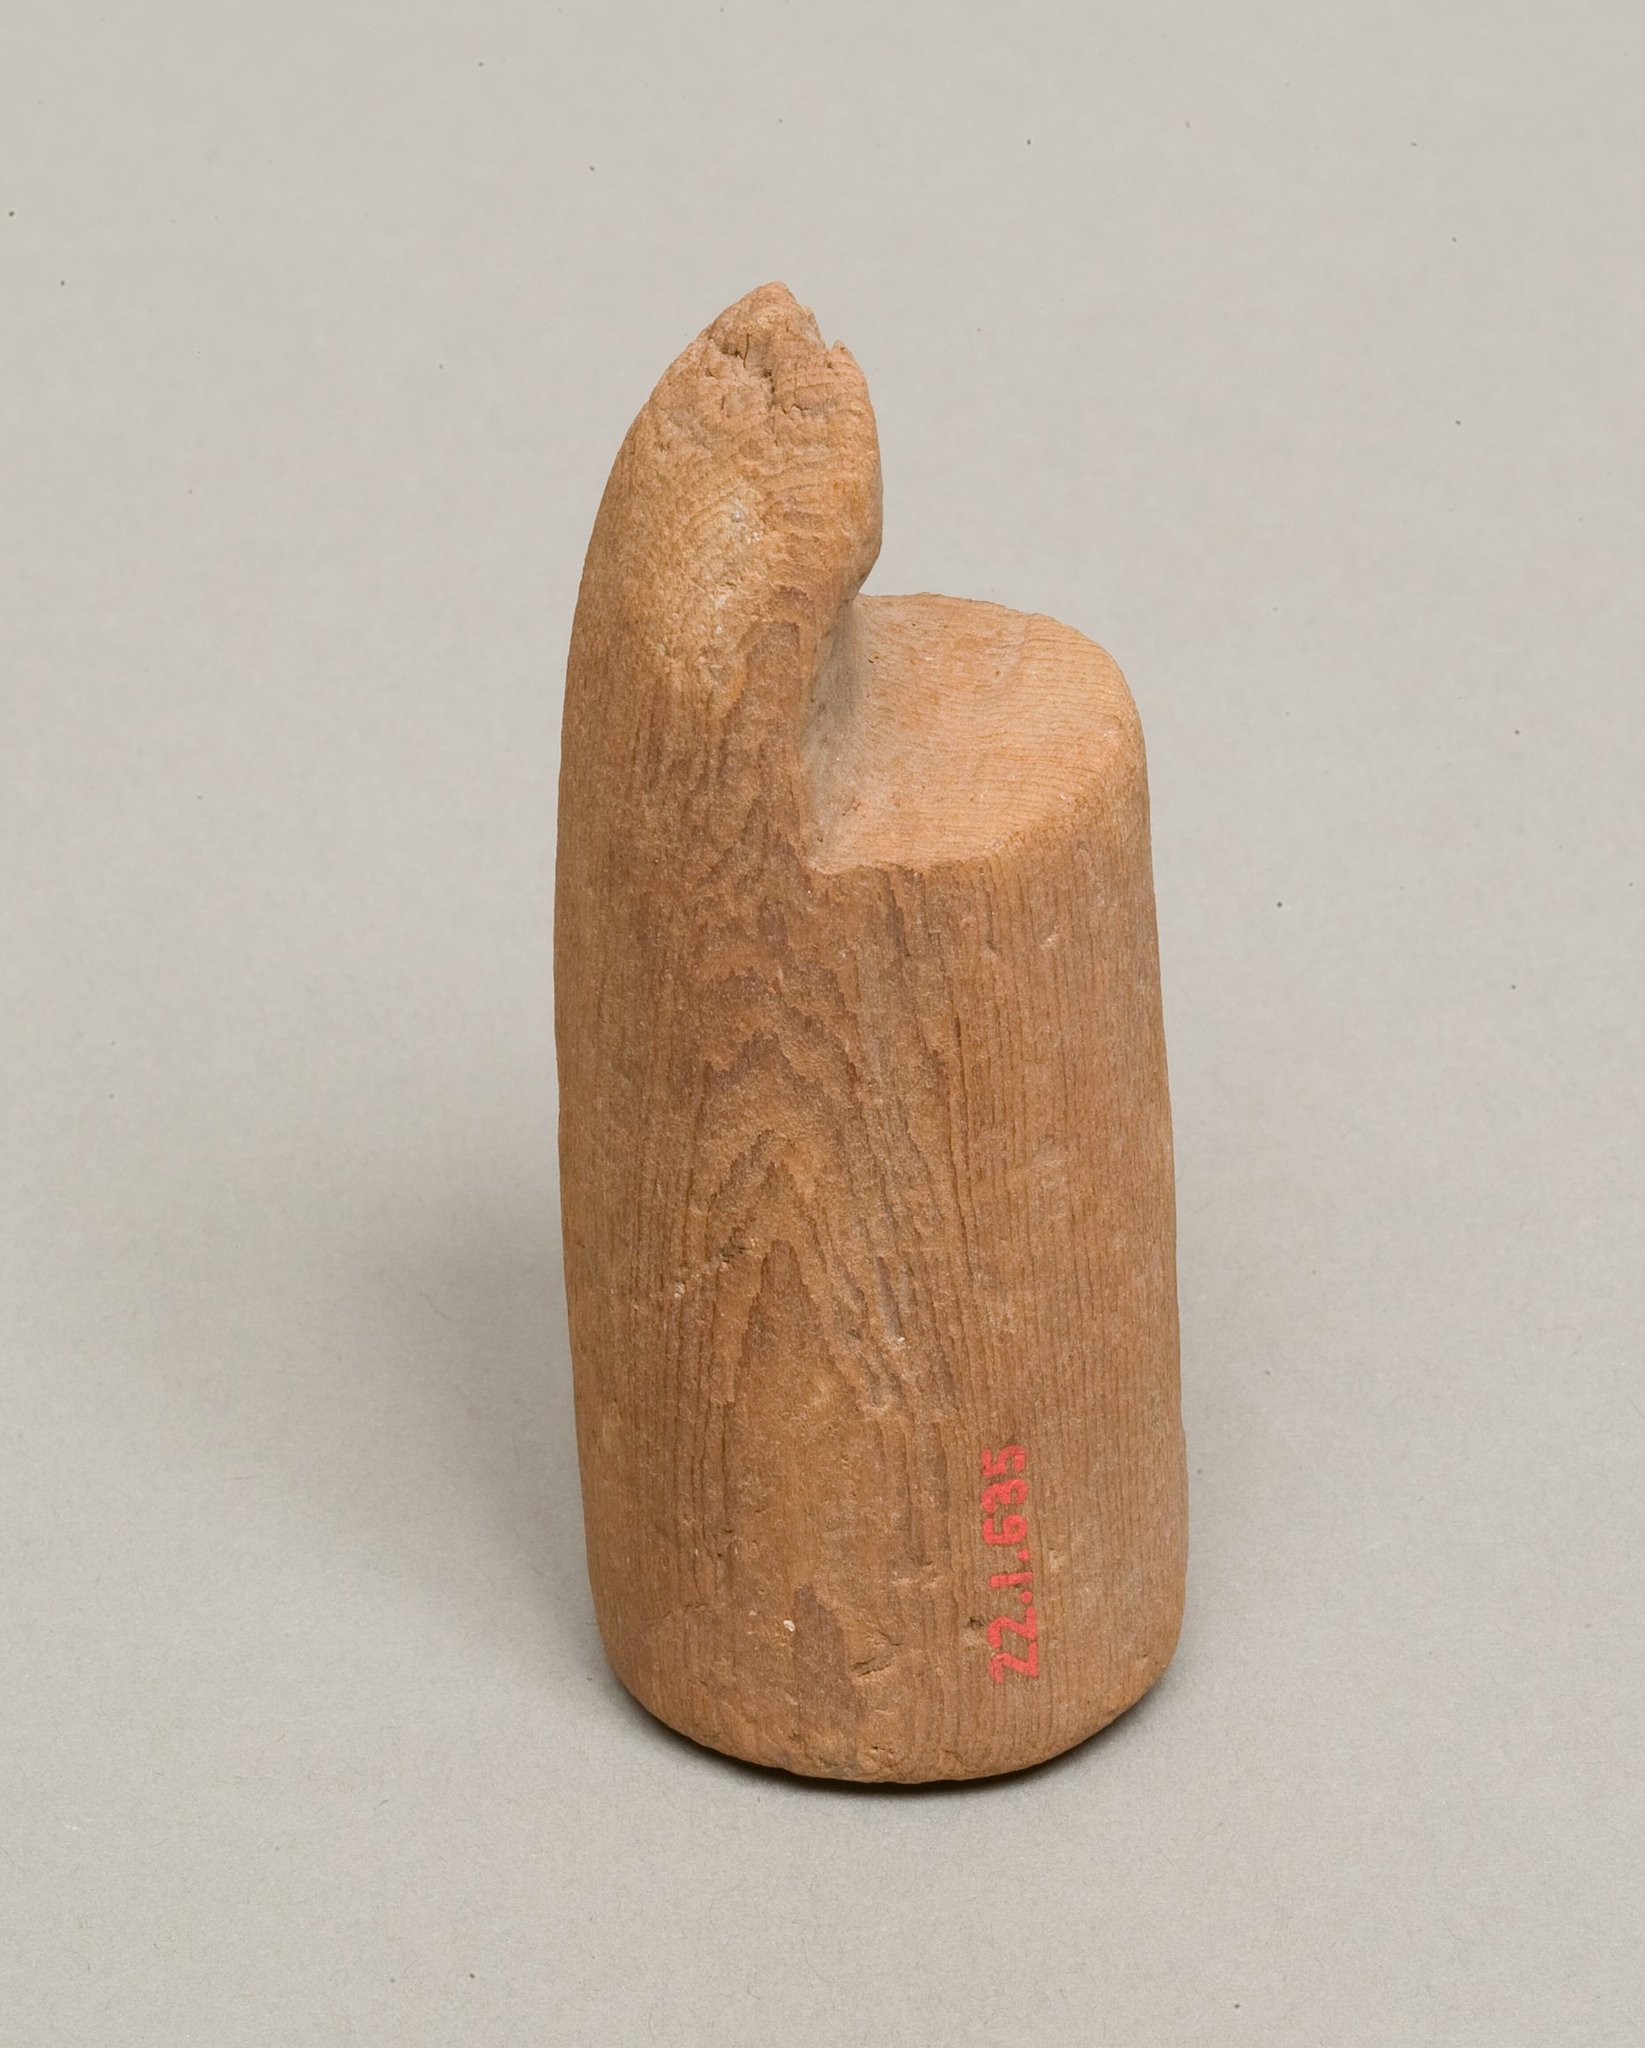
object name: small heddle jack from a loom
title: Loom equipment (?)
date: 1850-1070 BCE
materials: wood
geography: egypt